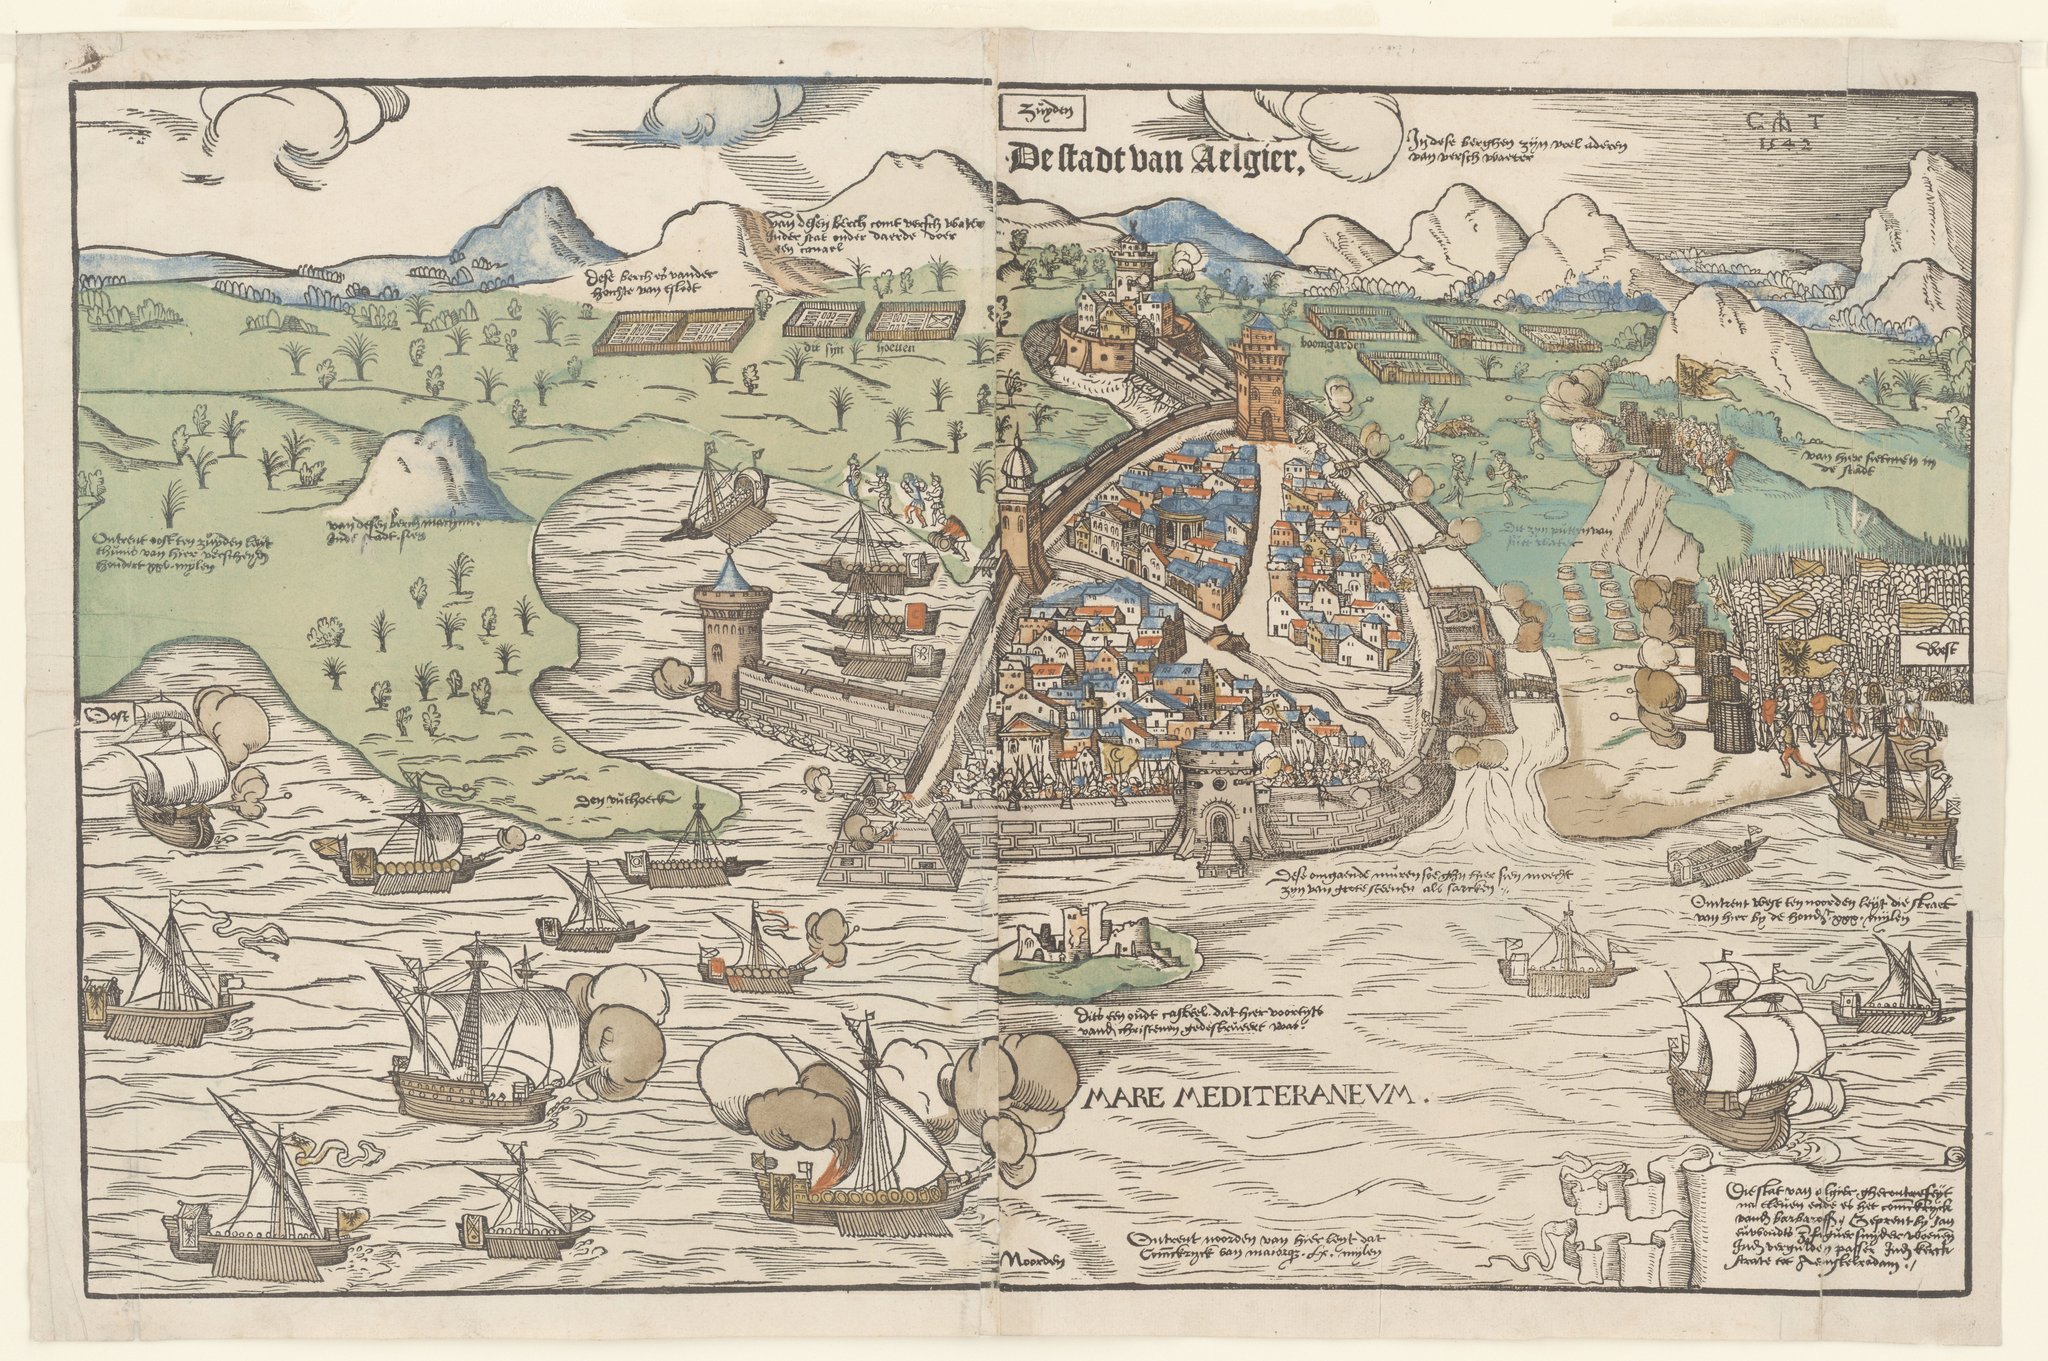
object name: print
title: Beleg van Algiers, 1541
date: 1542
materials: paper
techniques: hand coloring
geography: amsterdam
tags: siege (+ naval force)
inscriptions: collector's mark: Lugt 2228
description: Het beleg van de stad Algiers in 1541. Gezicht op de stad vanuit de Middellandse zee met zeilschepen die kanonnen afvuren.